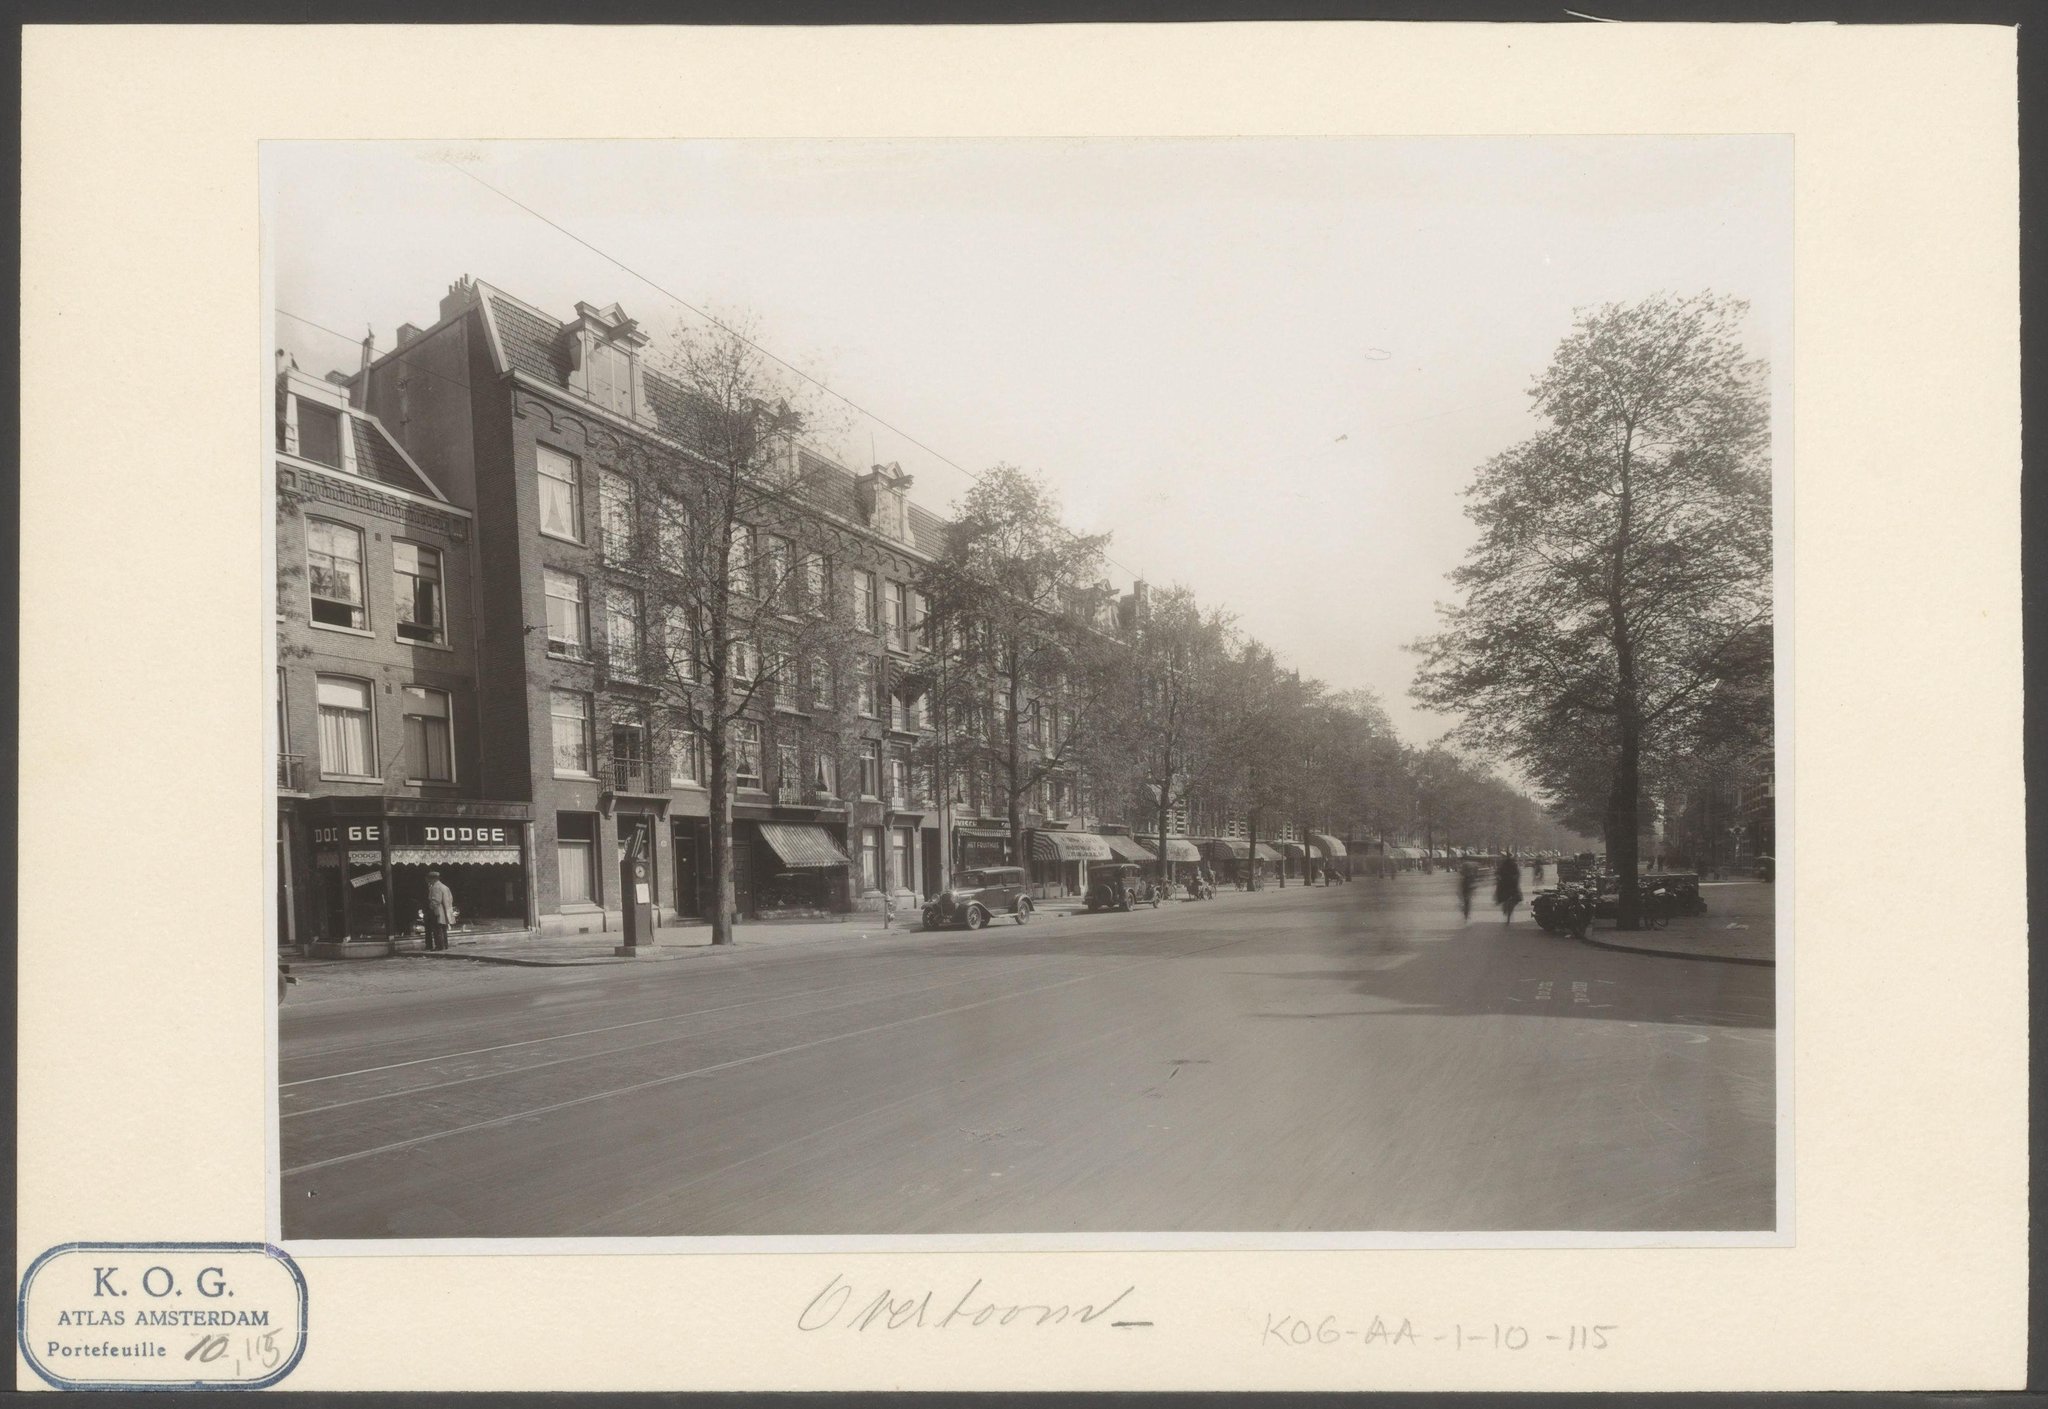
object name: photograph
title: Gezicht op de Overtoomseweg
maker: Anonymous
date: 1880-1950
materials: paper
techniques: gelatin silver print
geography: amsterdam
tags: city-view in general; 'veduta', the usual house or row of houses, street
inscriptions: collector's mark: ‘10,115’ Lugt 1641b, inscription: ‘Overtoom’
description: Onderwerpsrubriek binnen de Atlas Amsterdam: Overtoom.